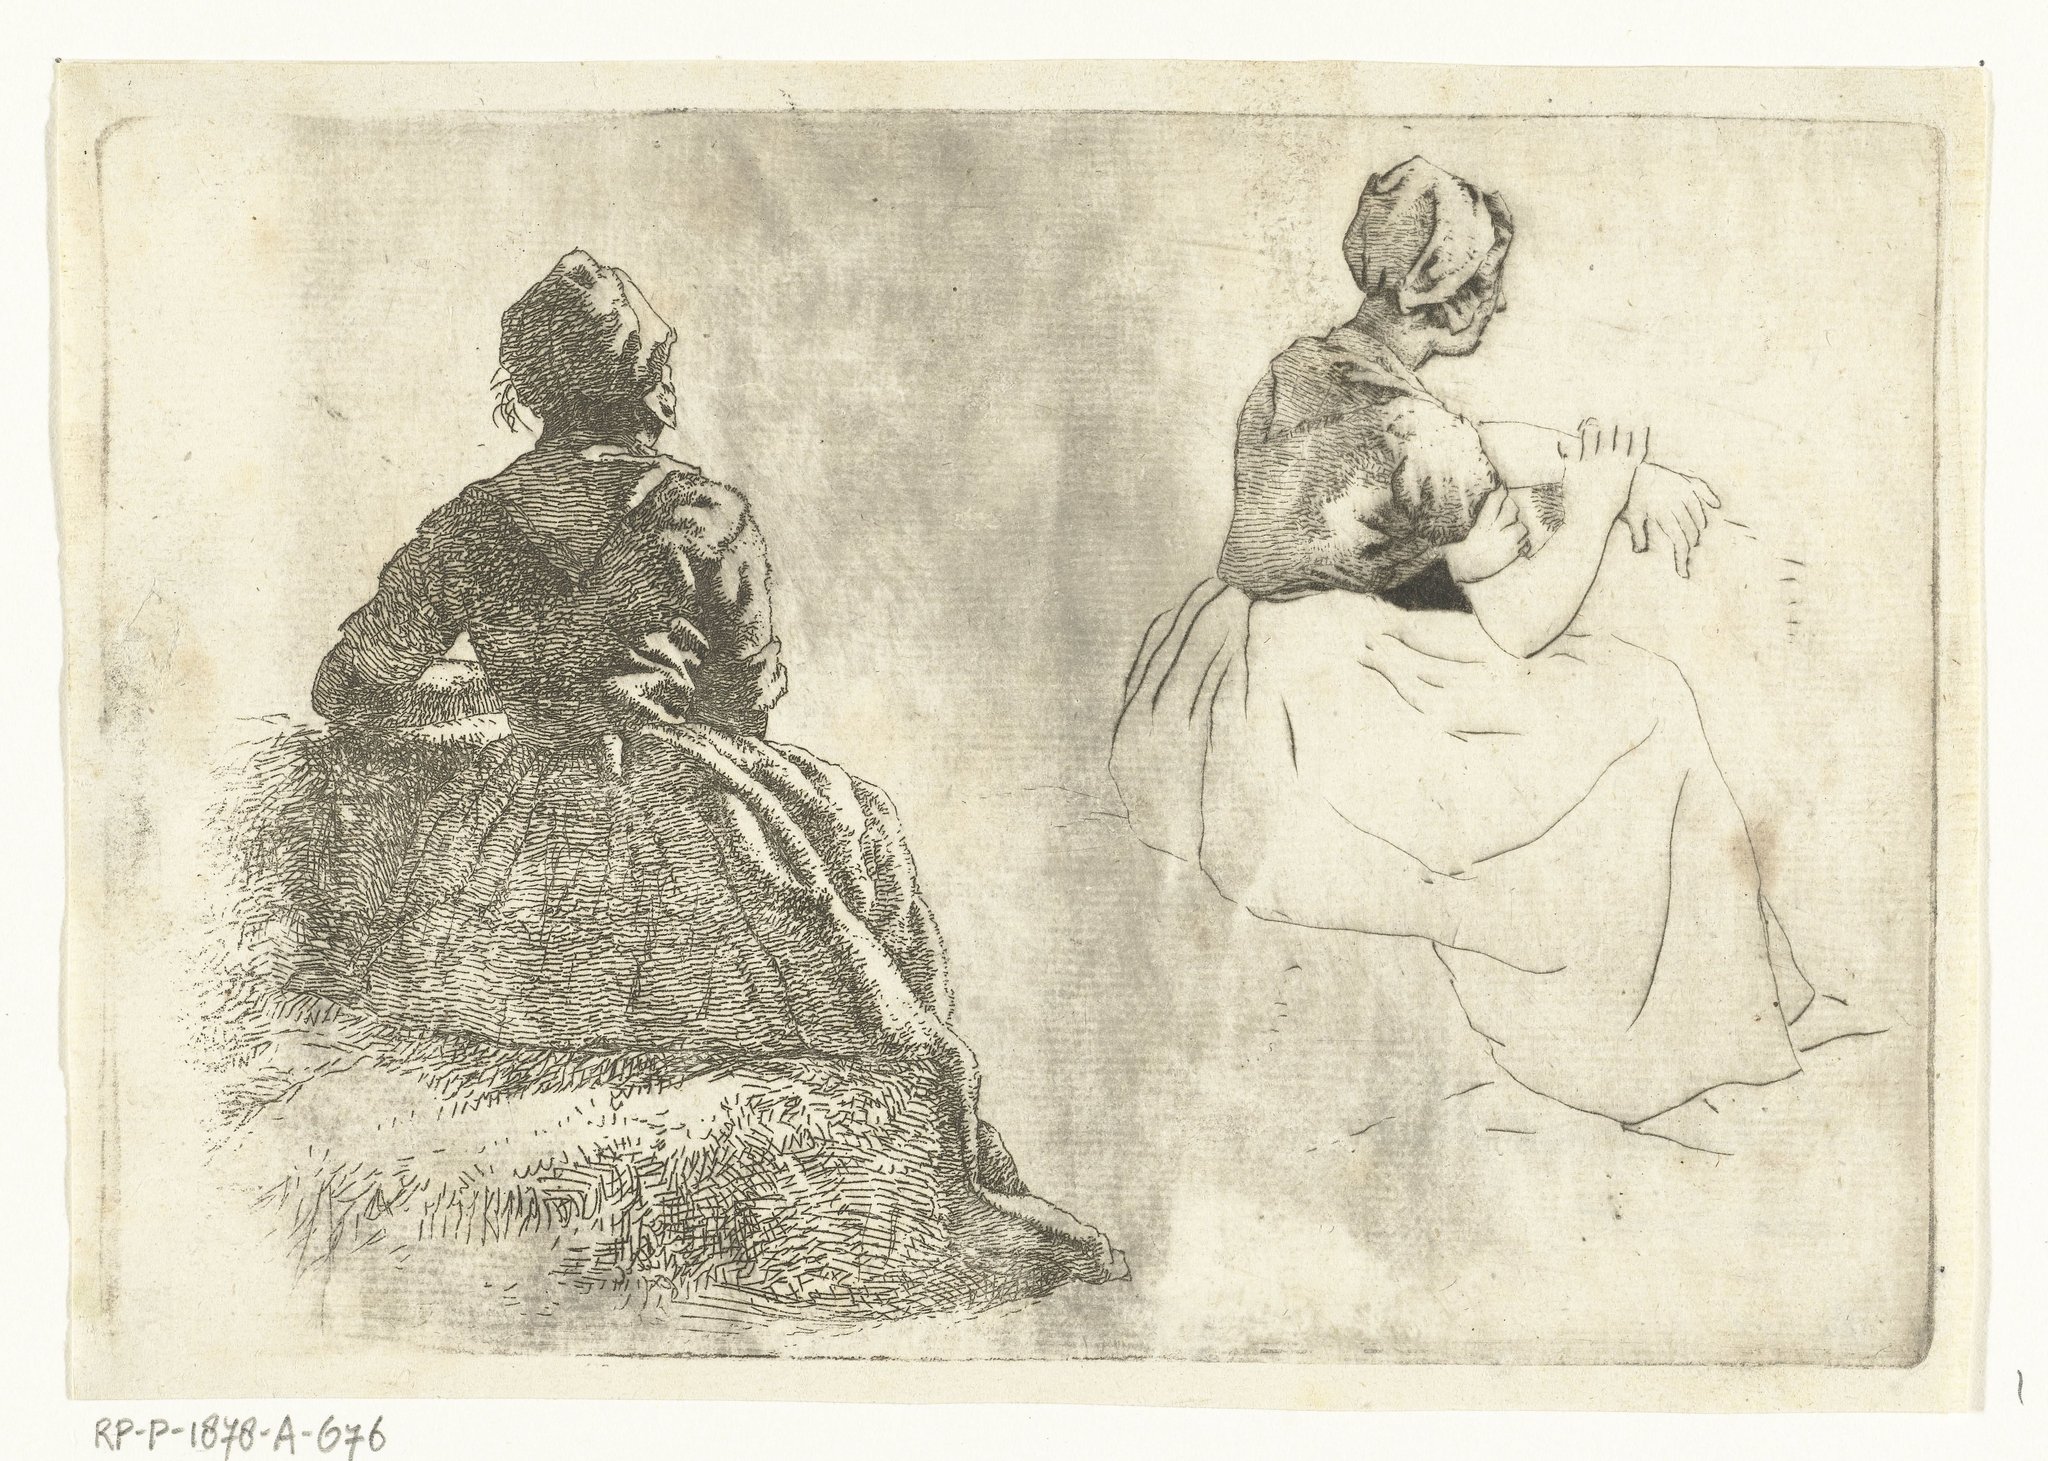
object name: print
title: Twee figuurstudies van boerin zittend op hooibaal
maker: albertus brondgeest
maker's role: draughtsman, print maker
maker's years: 1786-1849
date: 1796-1849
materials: paper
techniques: etching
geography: netherlands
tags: farmers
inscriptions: collector's mark: Lugt 2228